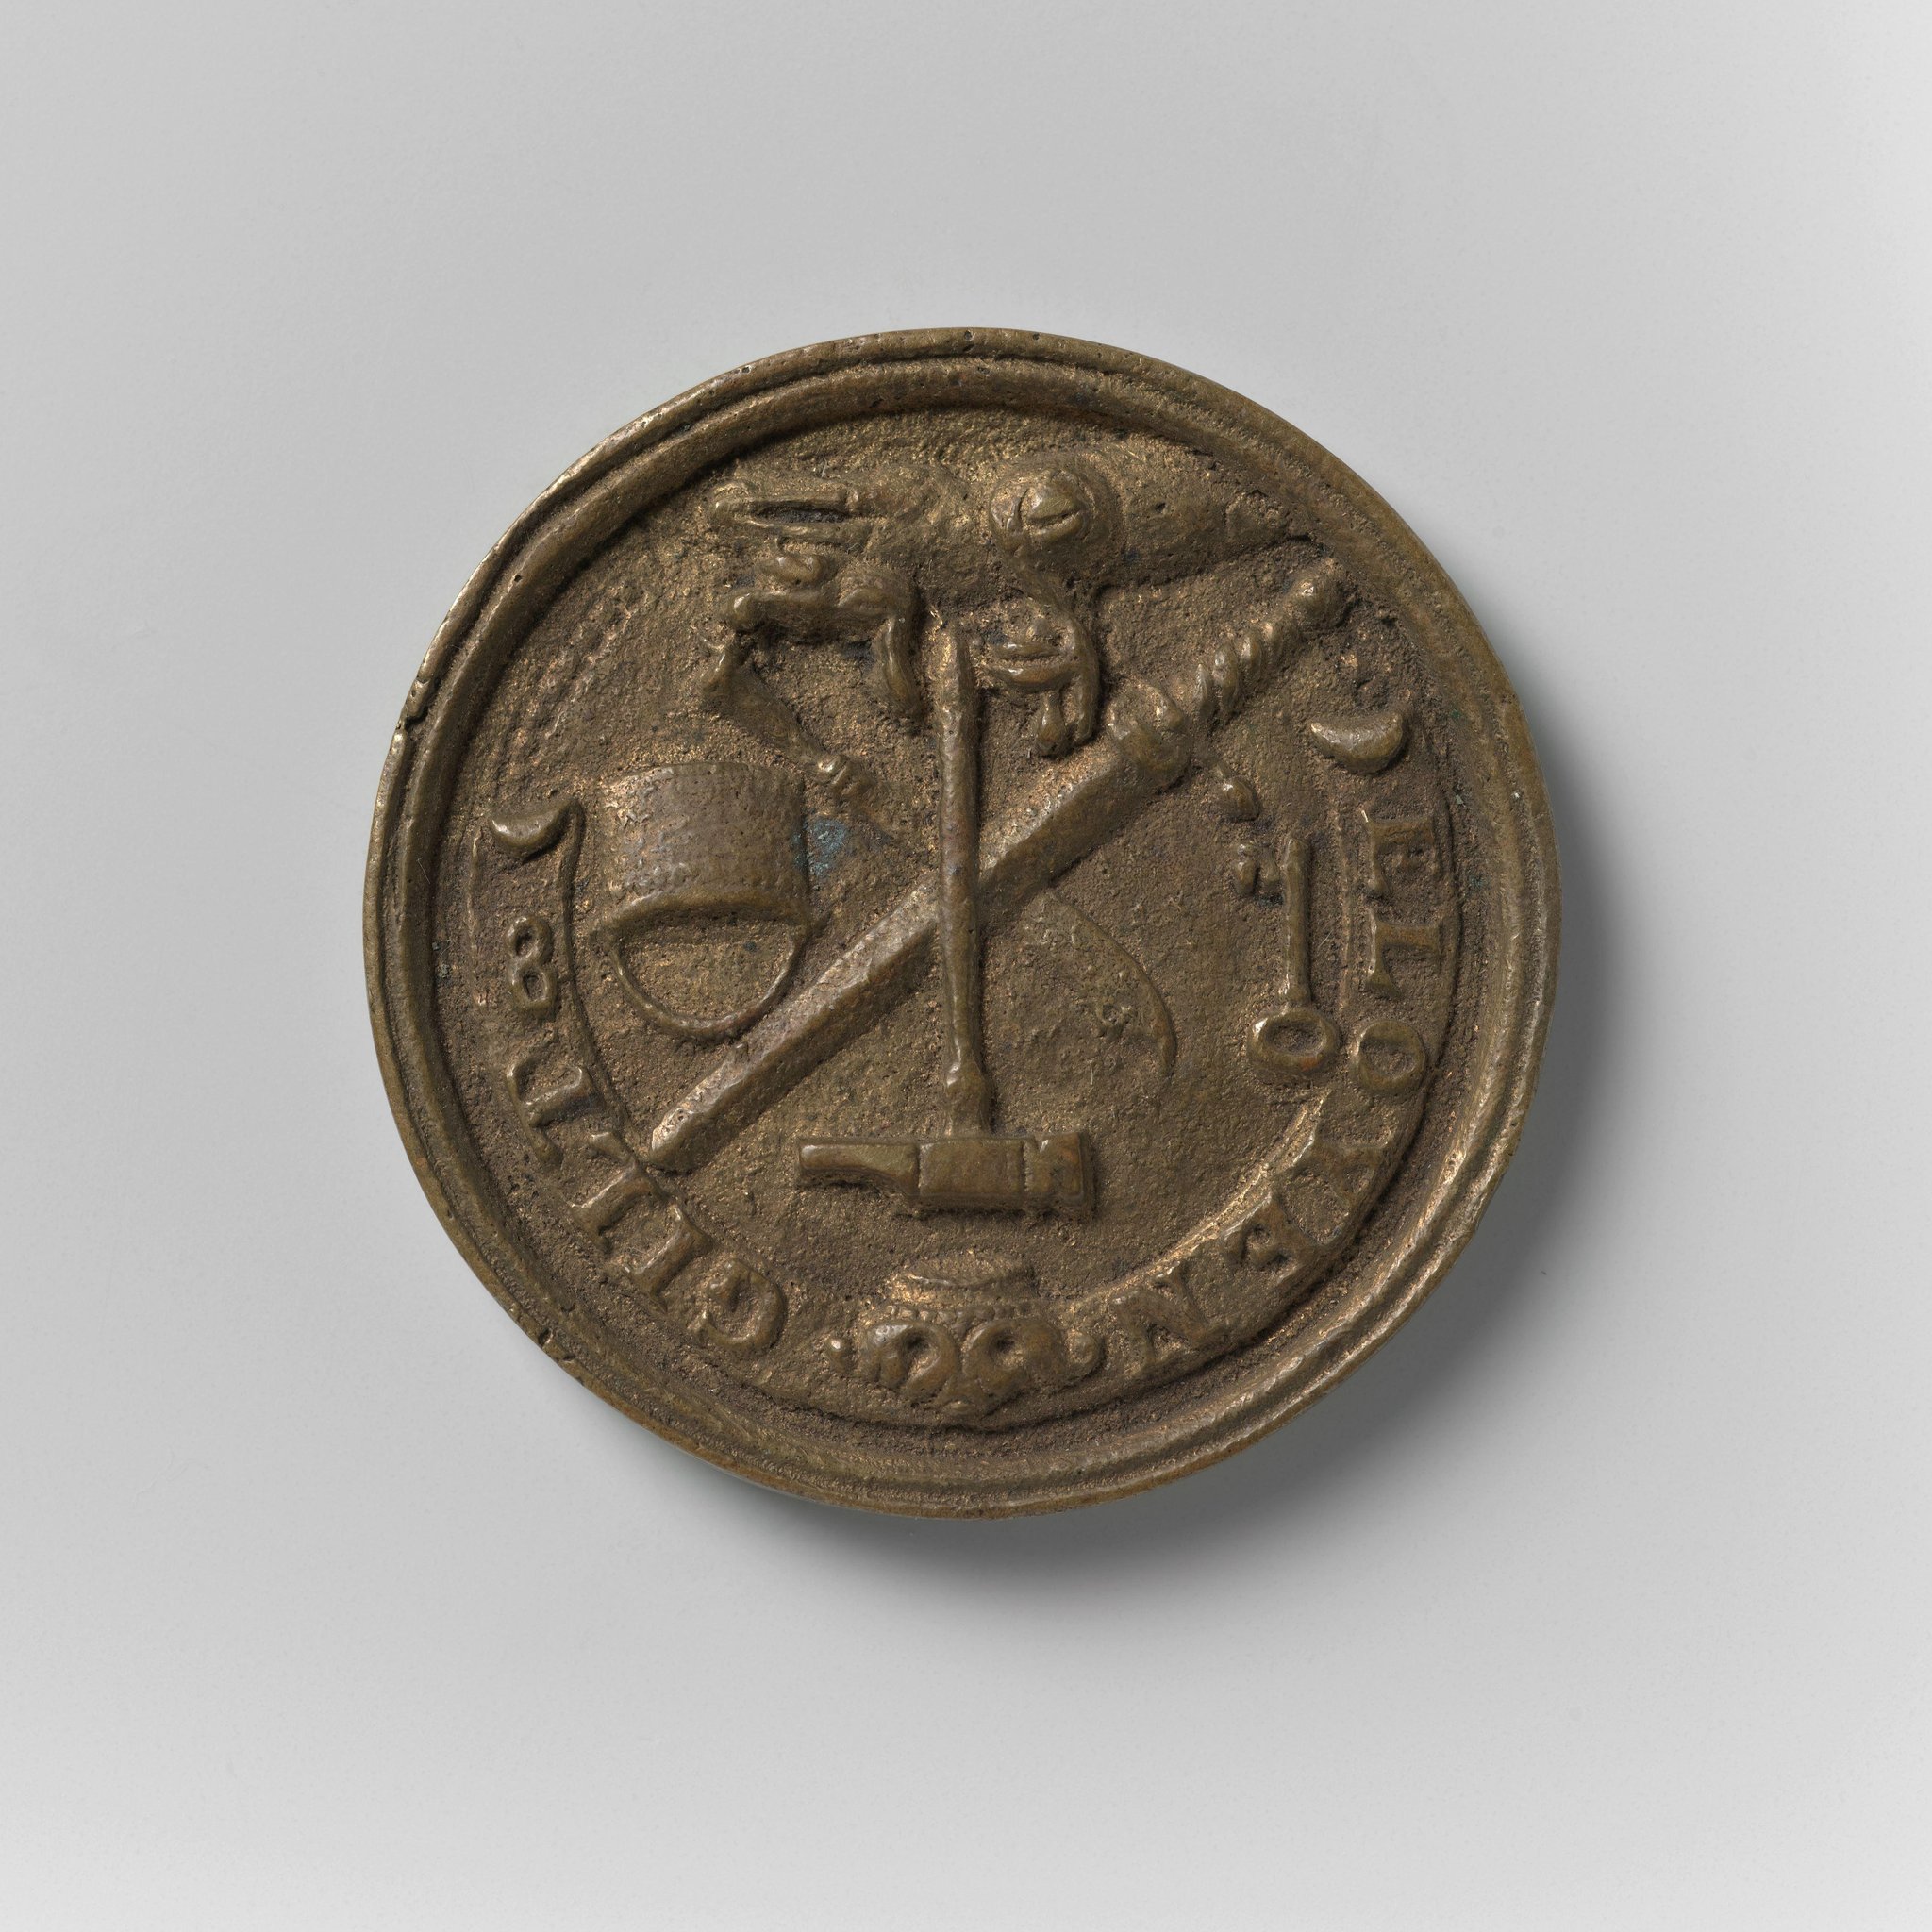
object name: medal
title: Gildepenning van het Smedengilde Sint Eloy te Amsterdam, op naam van Daniel Theodr Petti.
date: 1718-1789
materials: brass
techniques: casting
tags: goldsmith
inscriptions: circumscription: ‘ELOYEN - GILT’, inscription: ‘DANIEL / THEODR / PETTI / 1789’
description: Gegoten messing penning van het Smidsgilde, op de voorzijde een compostitie van hamer, zwaard, mes, sleutel, ketel en geweerslot met omschrift, op de keerzijde een gekroond wapenschild van Amsterdam met dragers boven een inscriptieruimte, op naam van Daniel Theodr Petti 1789